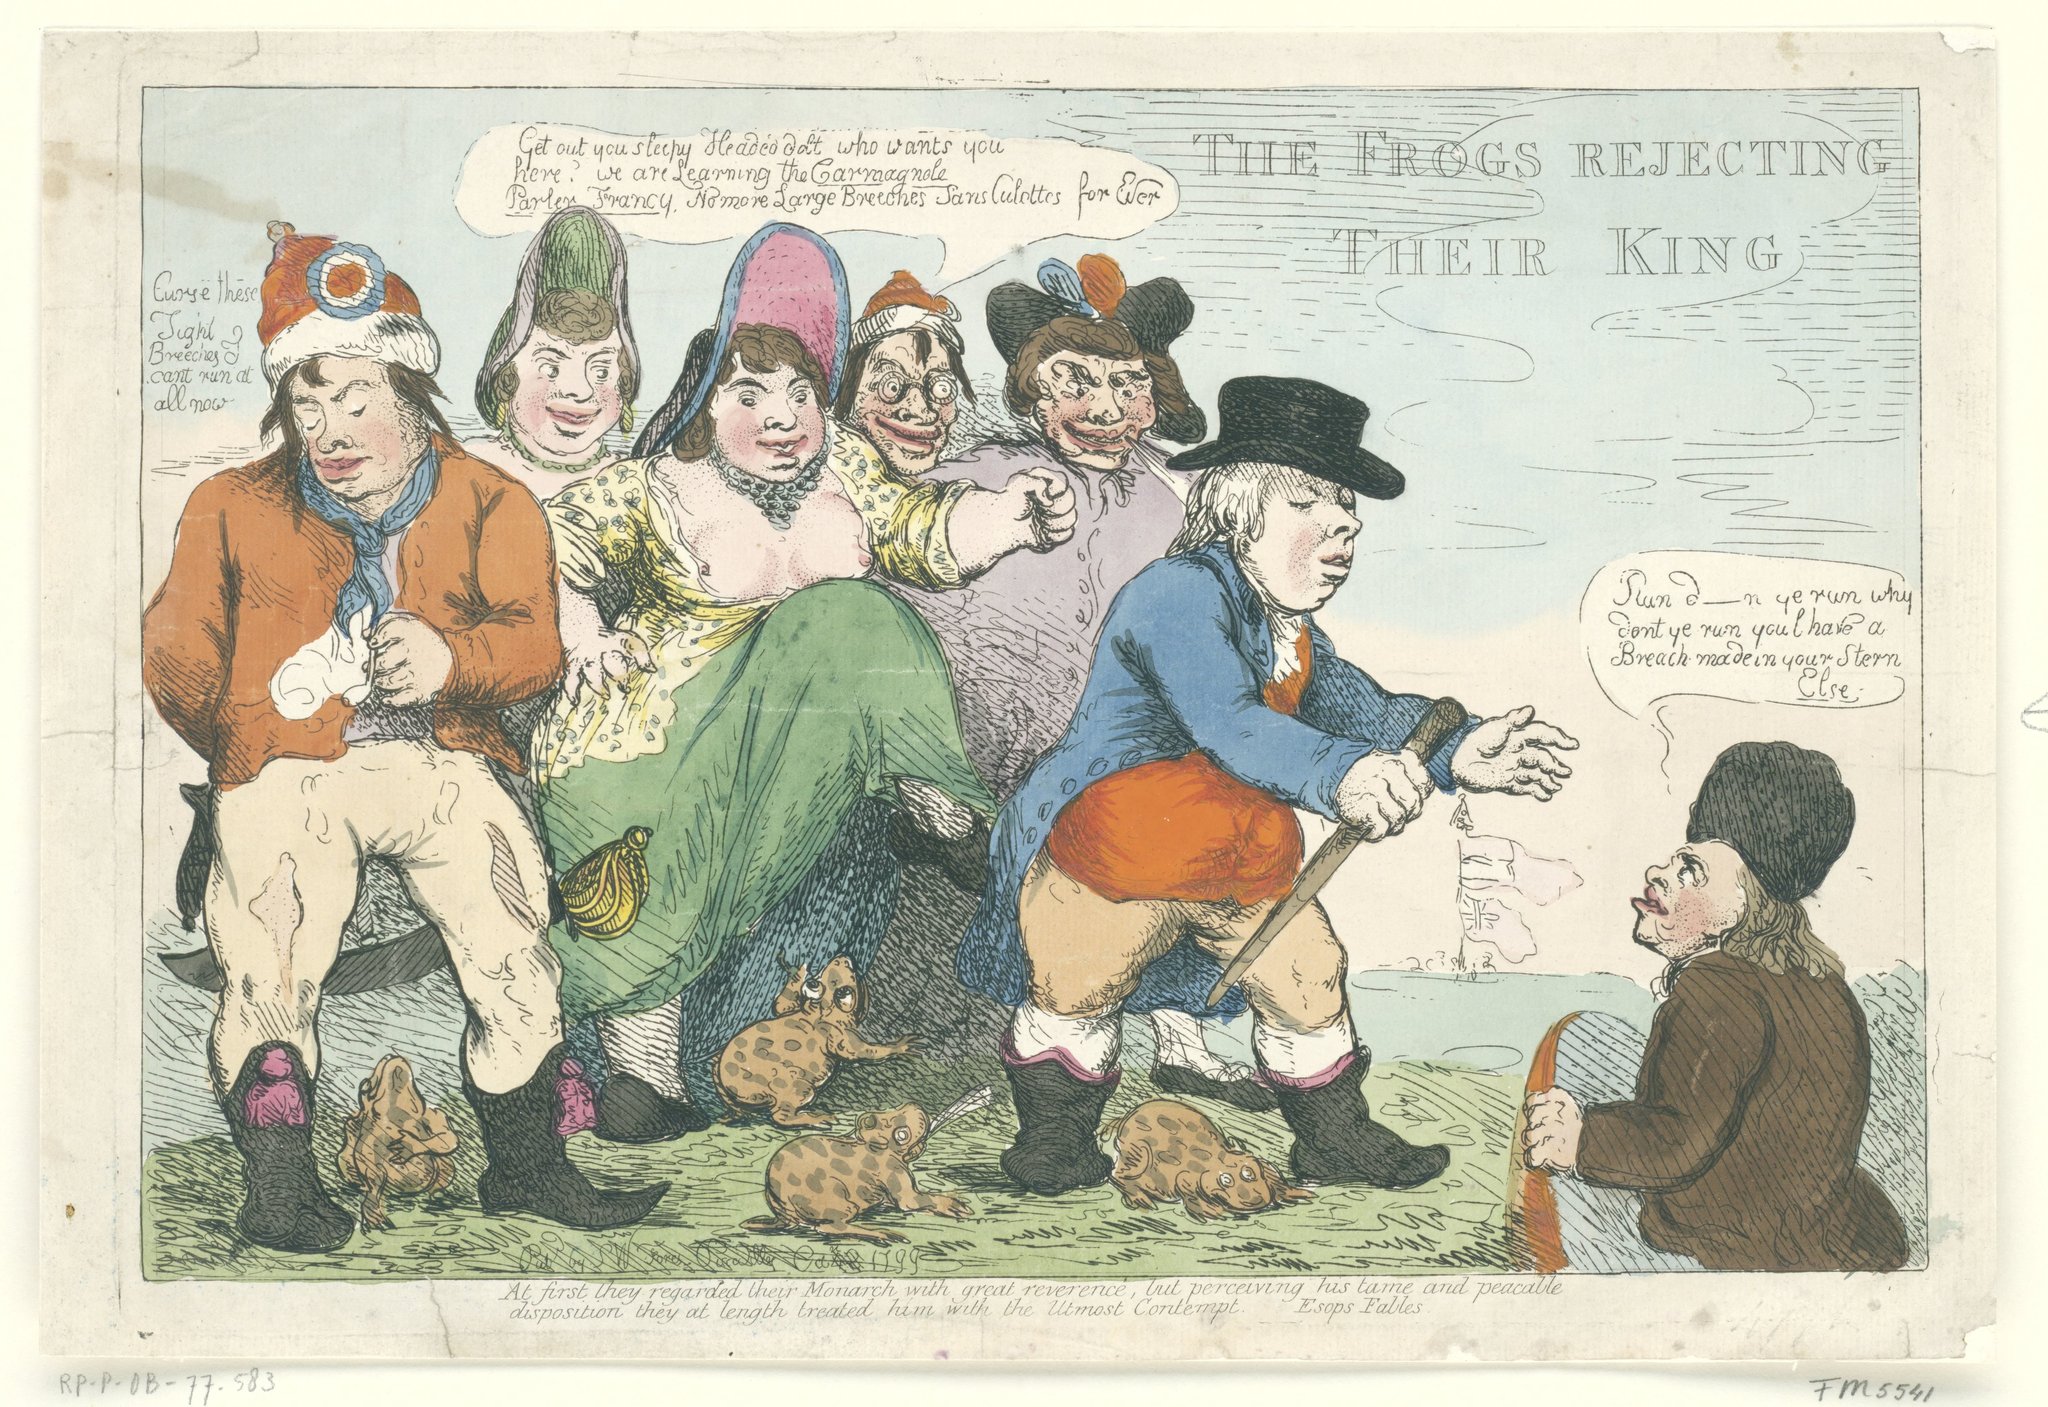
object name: print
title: The Frogs Rejecting Their King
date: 1710-1799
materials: paper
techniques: etching, hand coloring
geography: london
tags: the hague, william v (prince of orange), tailless amphibians: frog, kicking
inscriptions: collector's mark: Lugt 2228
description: Engelse spotprent op het mislukken van de Brits-Russische expeditie in Noord-Holland om het huis van Oranje in ere te herstellen. De blinde prins Willem V wordt door een Hollands viswijf met ontblote borsten en andere figuren bespot en met een trap op zijn achterste weggejaagd. Rechts een Engelse bootsman die prins weer ophaalt. Op de grond een aantal kikkers (Hollanders) Met een onderschrift uit één van de Aesopische fabels.